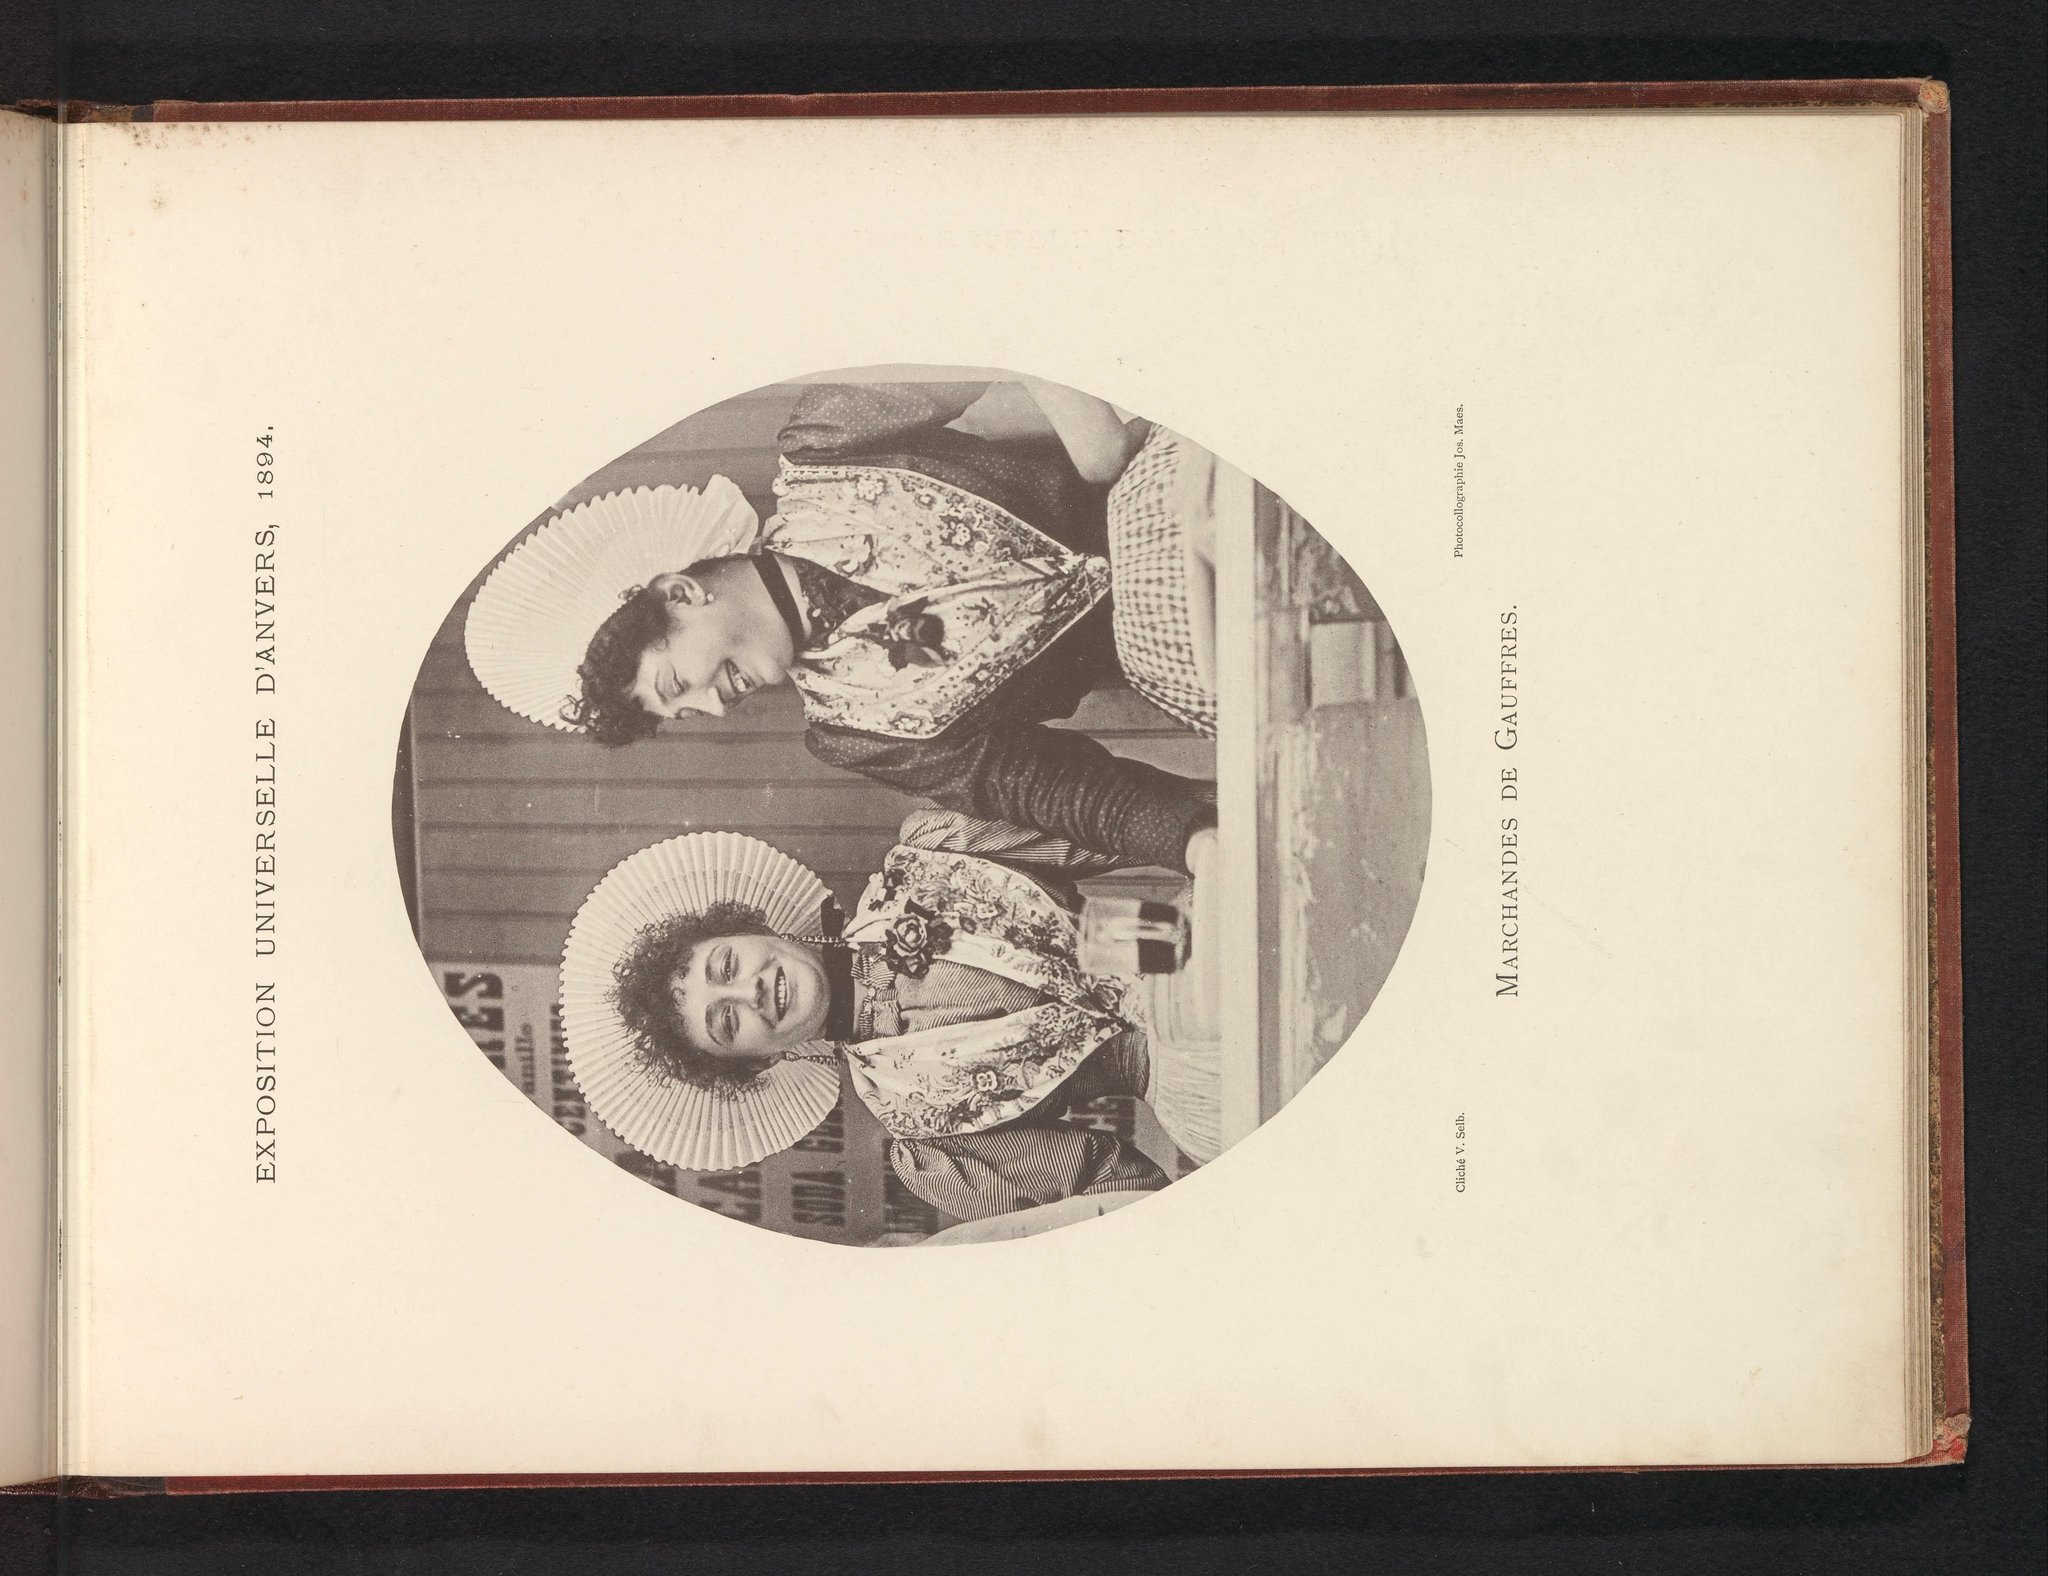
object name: page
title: Portret van twee wafelverkoopsters te Antwerpen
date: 1890-1894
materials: paper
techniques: photograph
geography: antwerp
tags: merchant, salesman - bb - women engaged in trade and commerce, waffles